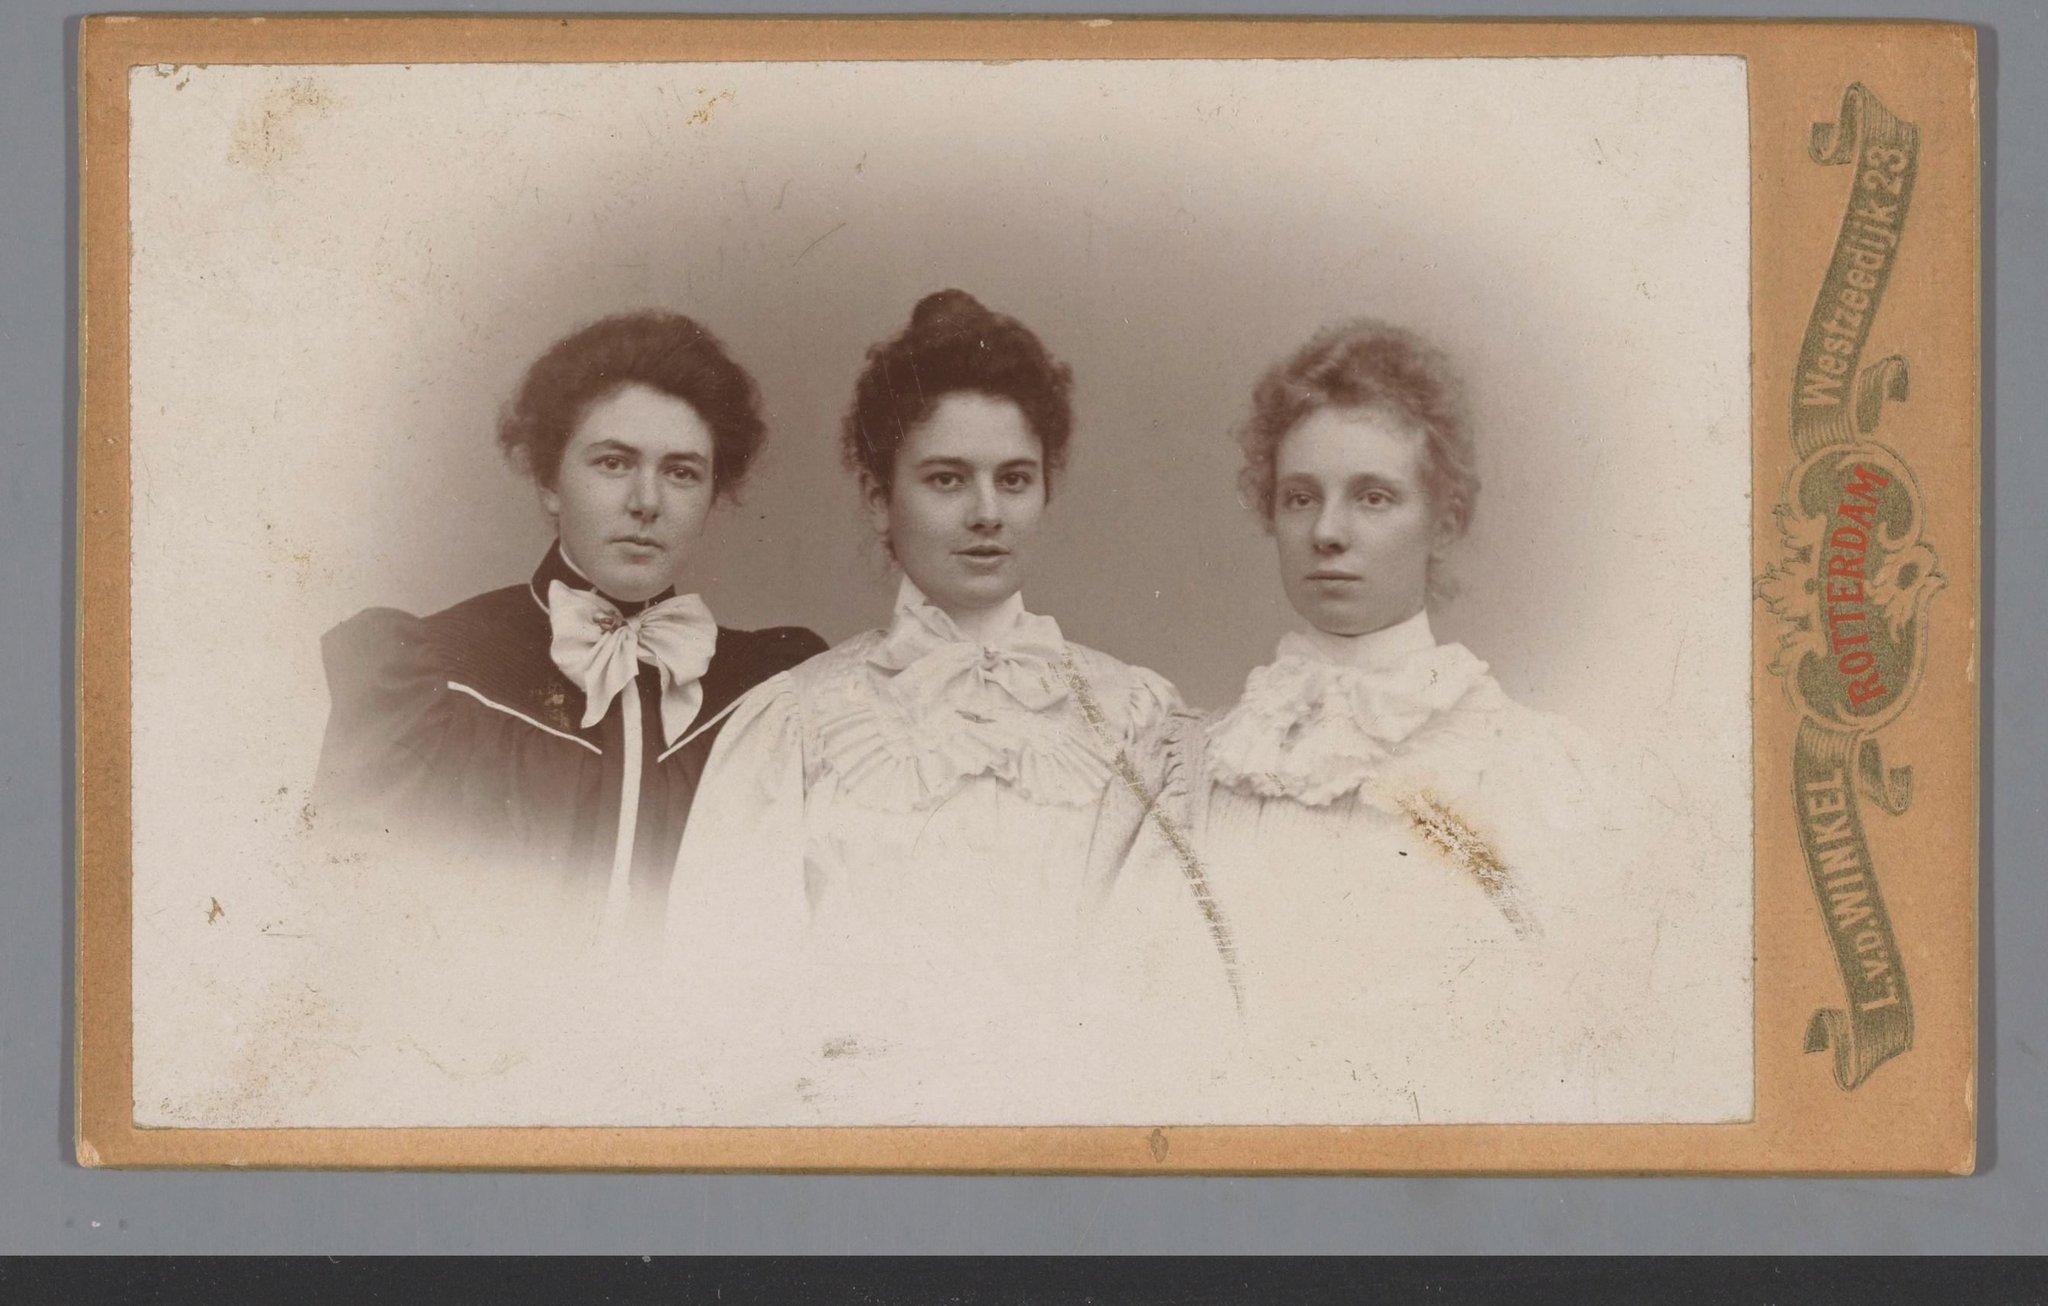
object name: carte de visite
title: Portret van drie vrouwen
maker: lodewijk van de winkel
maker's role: fotograaf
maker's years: 1856-1919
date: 1898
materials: cardboard, paper, photographic support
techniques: albumen print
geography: rotterdam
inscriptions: annotation: ‘Ter herinnering aan 14 Oct. 1898’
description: Drie jonge vrouwen naast elkaar, en buste.